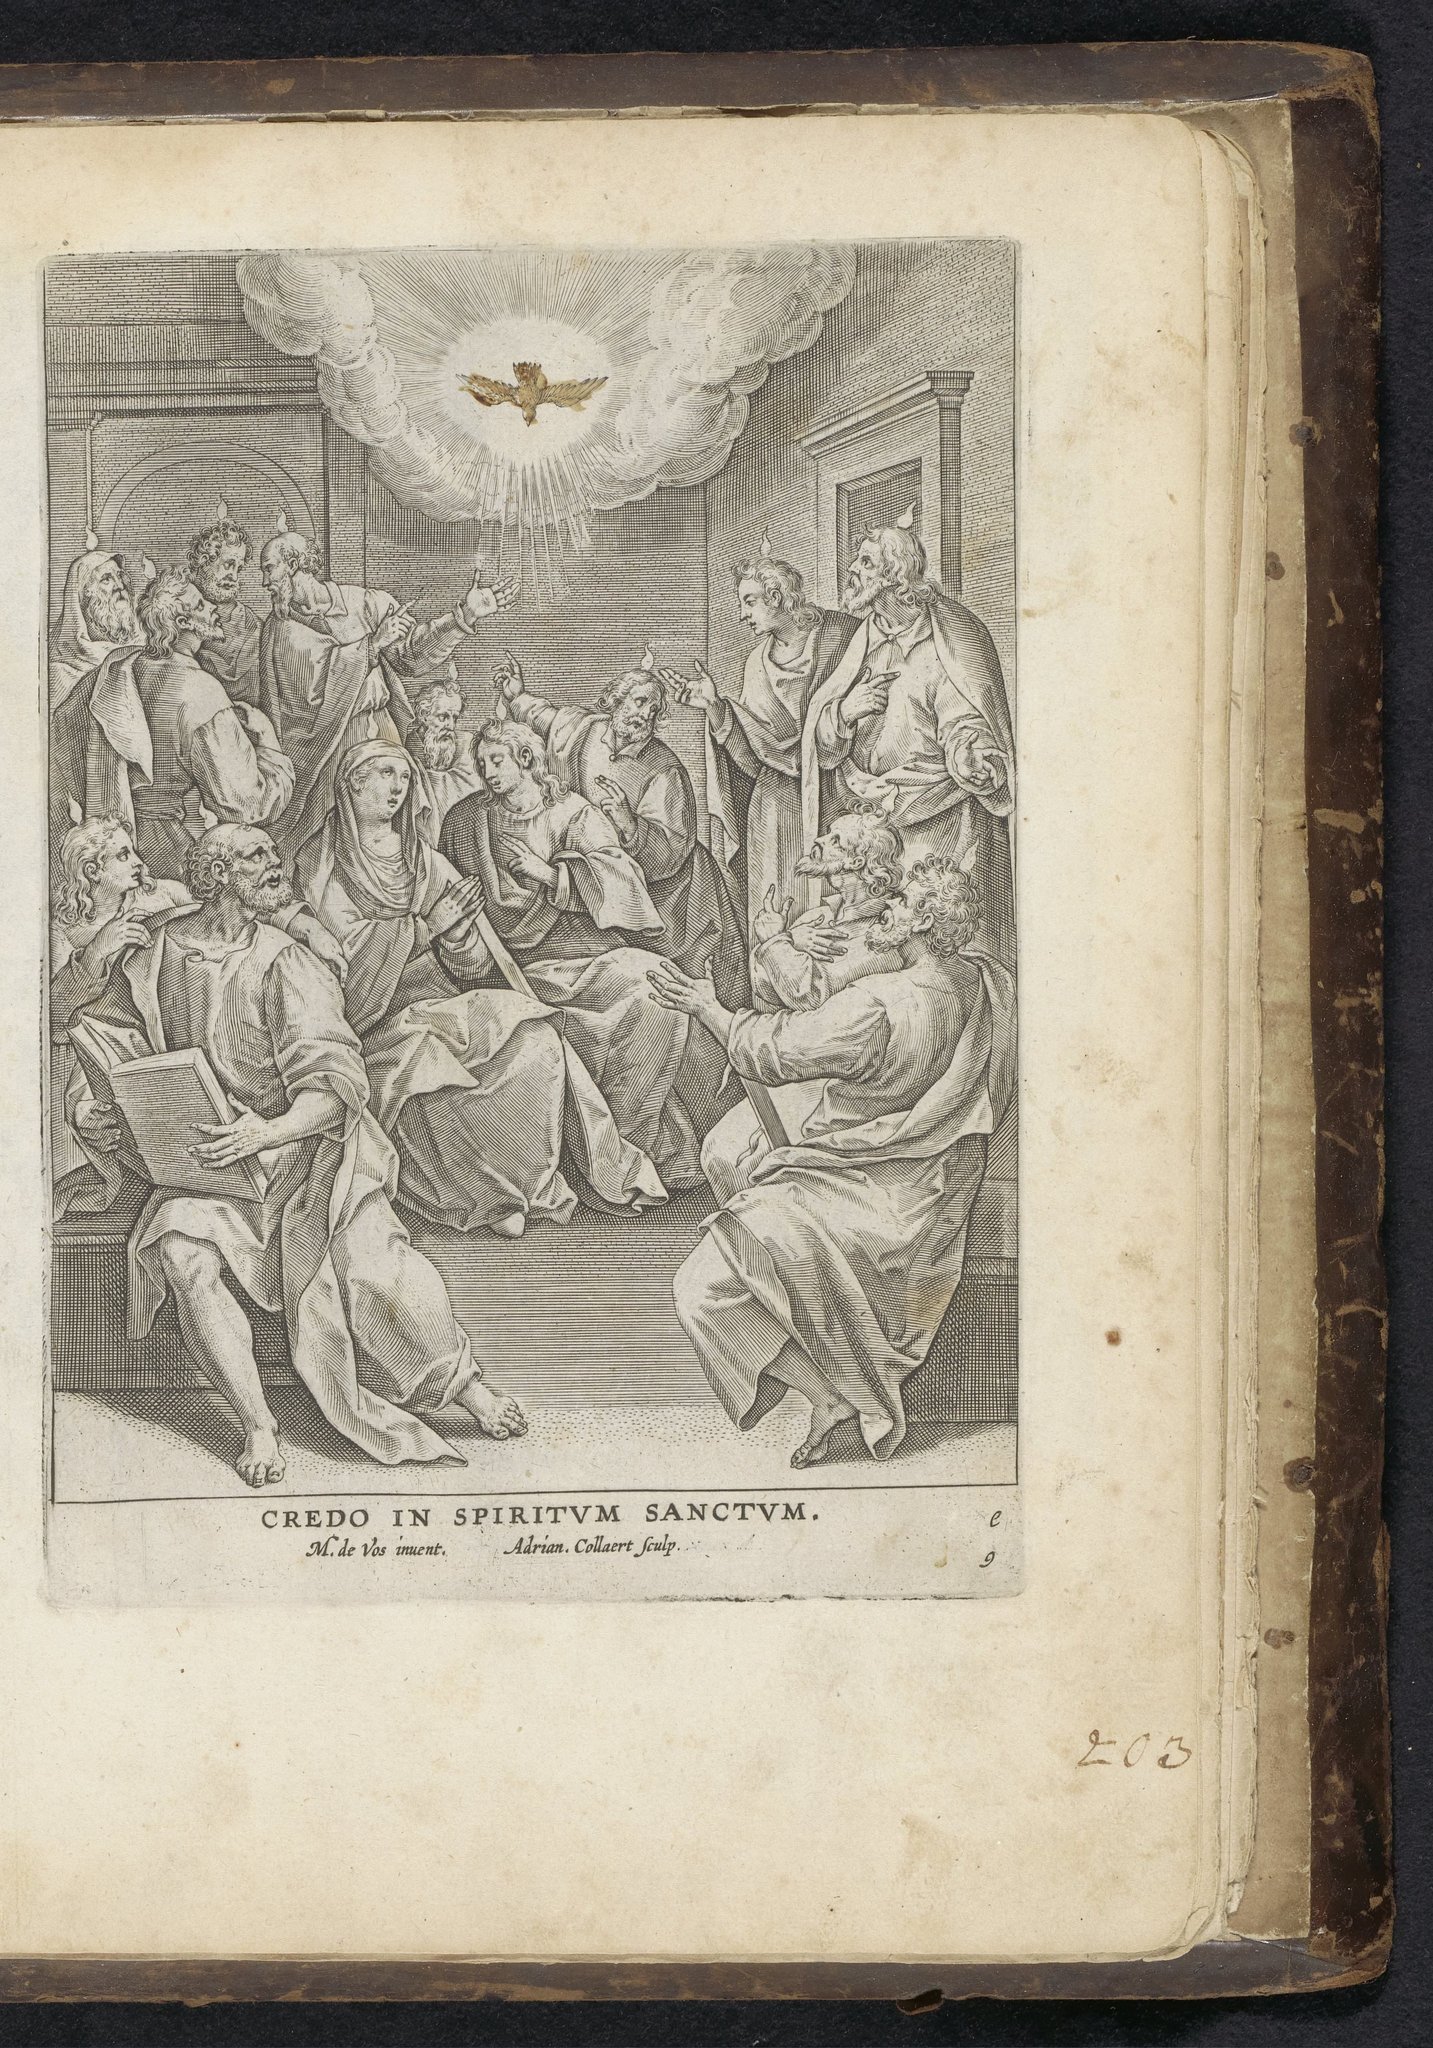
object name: album leaf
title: Uitstorting van de Heilige Geest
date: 1570-1618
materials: paper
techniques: engraving, hand coloring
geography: amsterdam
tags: 'credo in spiritum sanctum' ~ articles of faith, pentecost: the holy ghost descends upon (mary and) the apostles, sometimes paul and/or representatives of the nations present (acts 2:1-4)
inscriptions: number: ‘203’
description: Illustratie van het achtste geloofsartikel (Ik geloof in de heilige Geest) van de apostolische geloofsbelijdenis. Maria en de twaalf apostelen zitten in een kamervertrek. Vurige tongen branden boven hun hoofden. De Heilige Geest, in de gedaante van een duif, zweeft boven de apostelen, omgeven door lichtstralen. Deze prent maakt deel uit van een album.